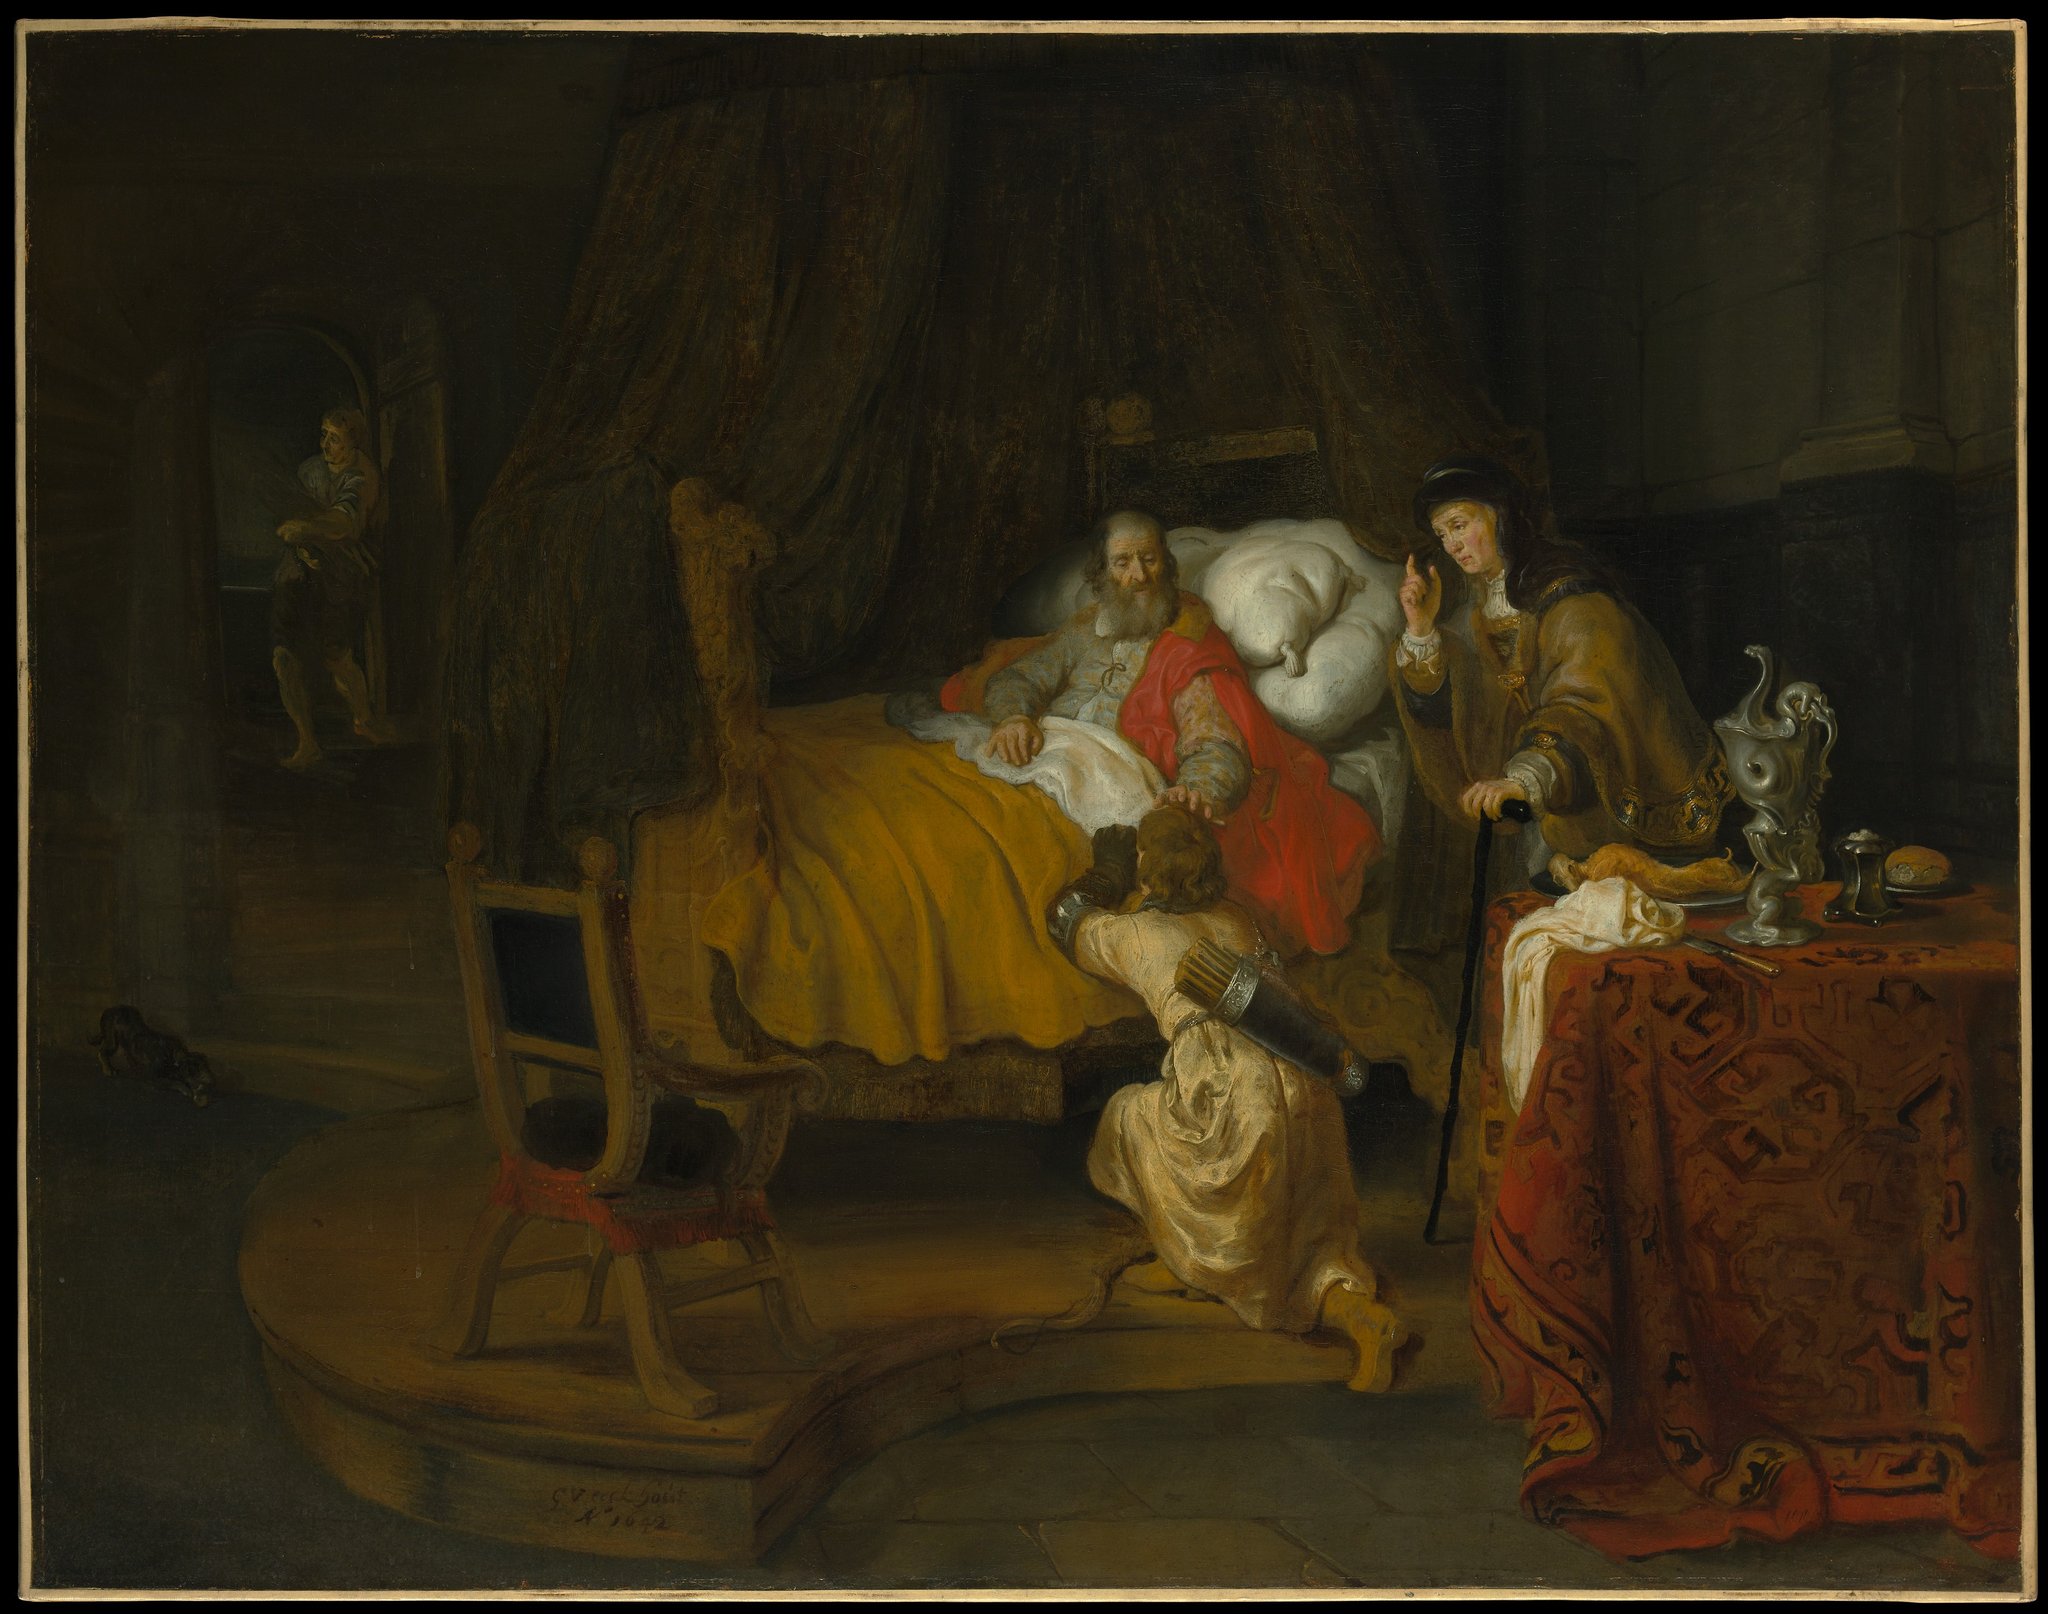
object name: painting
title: Isaac Blessing Jacob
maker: gerbrand van den eeckhout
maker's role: artist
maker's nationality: dutch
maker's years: 1621-1674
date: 1642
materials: canvas, oil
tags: interiors,bedrooms,men,women,beds